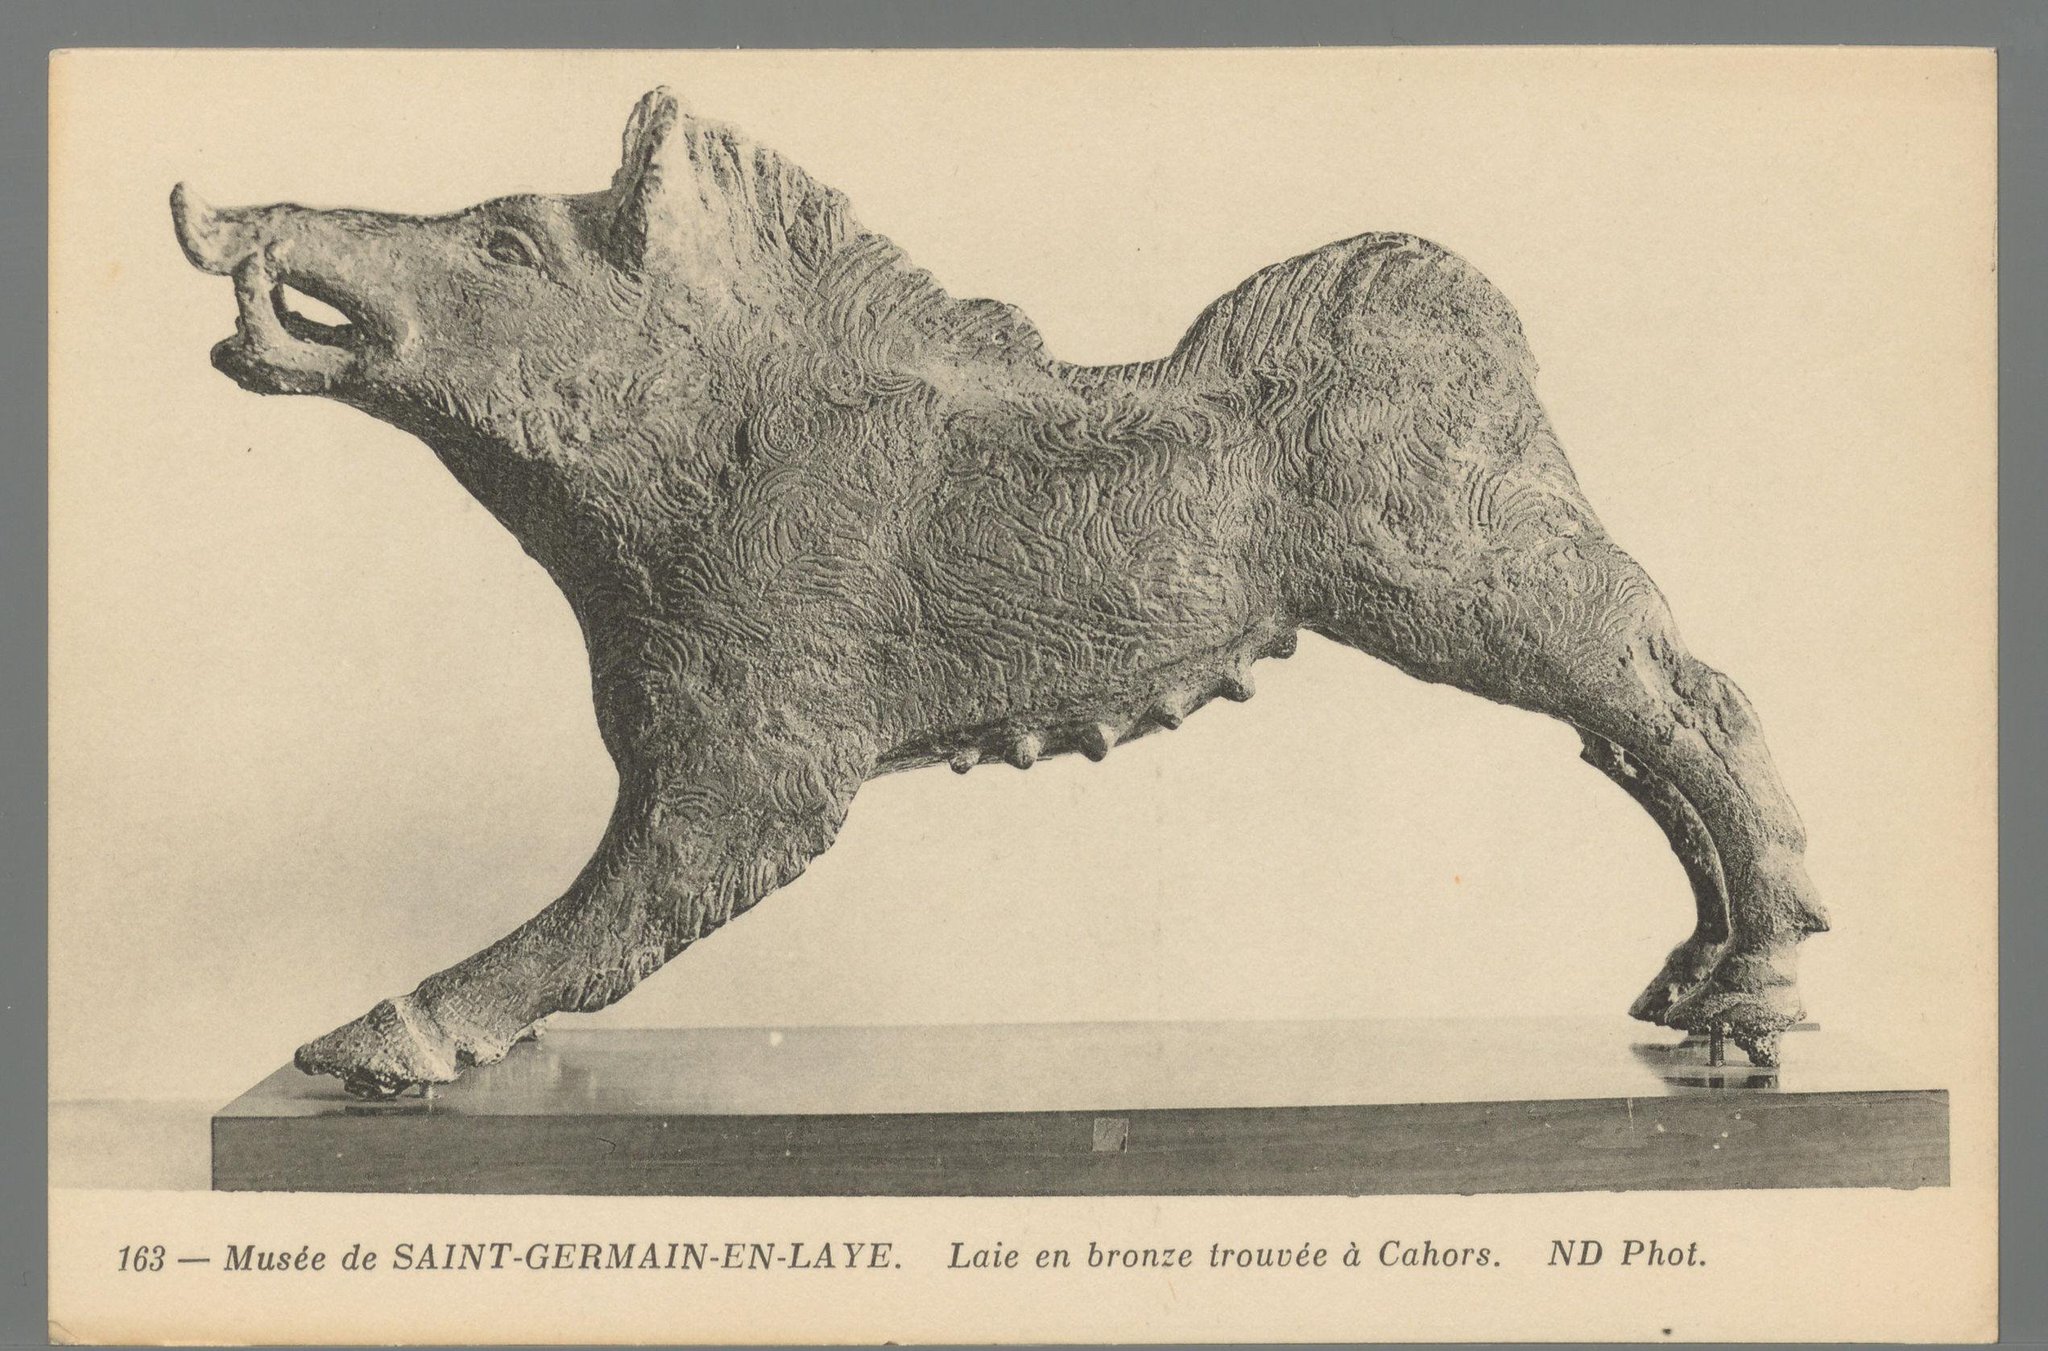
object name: ansichtkaart, prentbriefkaart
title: Laie en bronze trouvée à Cahors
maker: Anonymous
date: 1903-1918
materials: cardboard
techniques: photograph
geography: saint-germain-en-laye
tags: sow, monument, statue, permanent exhibition, museum